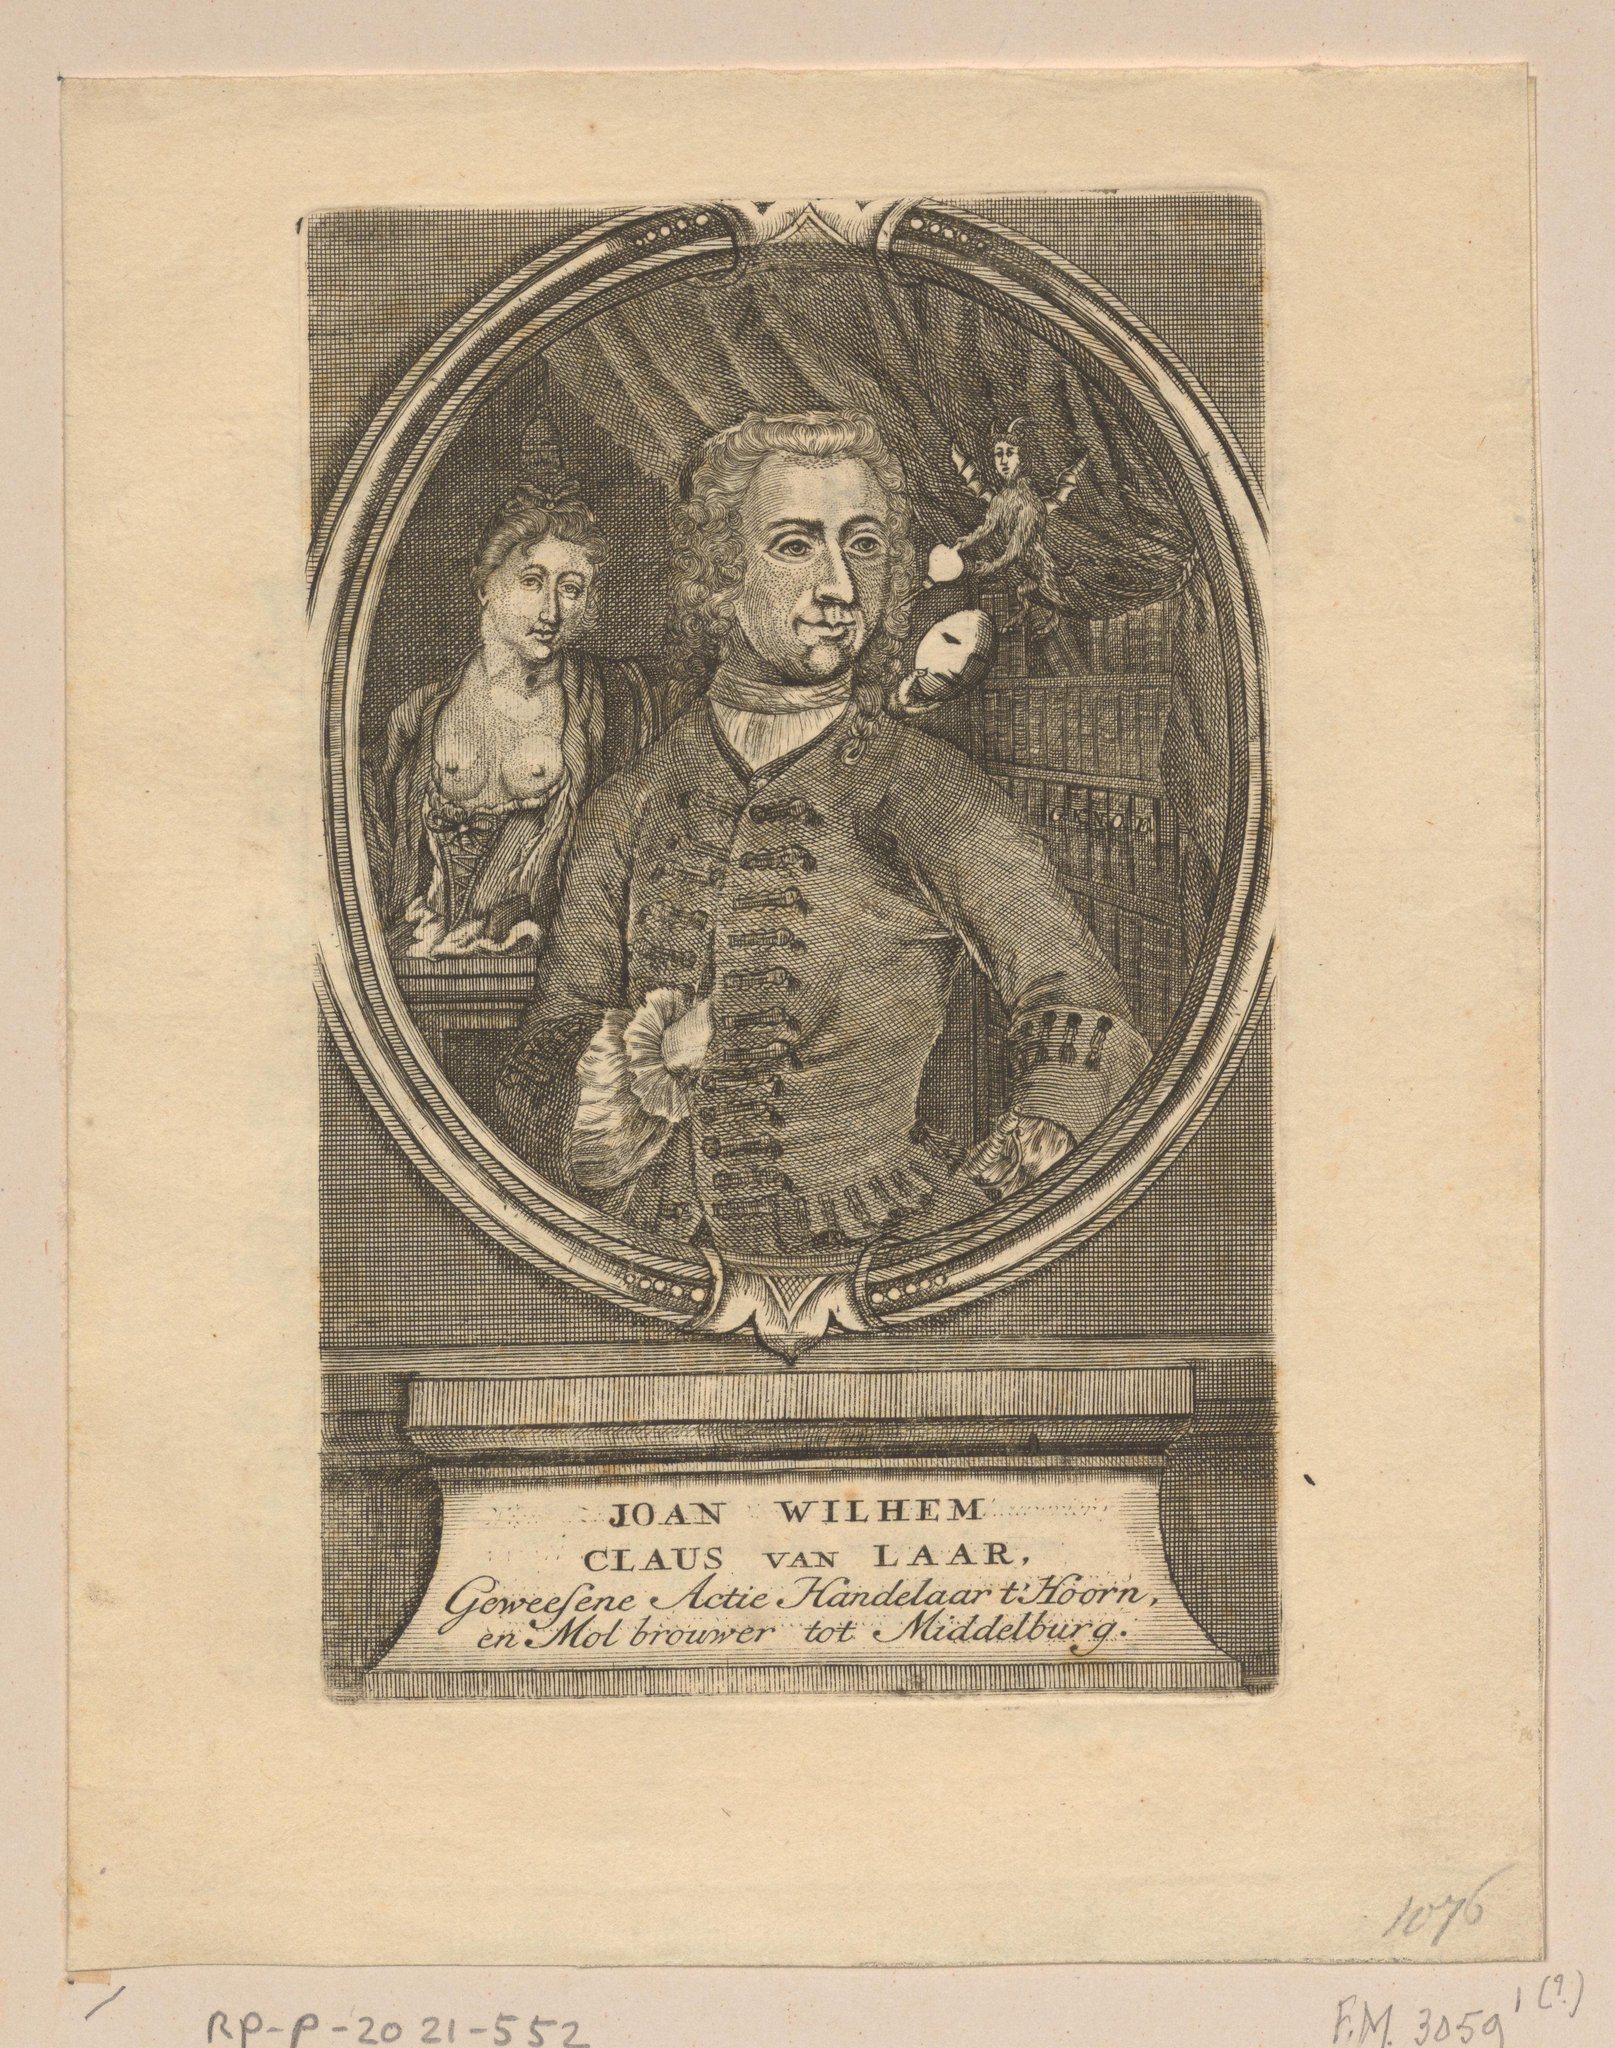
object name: book illustration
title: Portret van Johan Willem Claus van Laar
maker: Anonymous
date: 1746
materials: paper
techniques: engraving, etching, letterpress printing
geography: netherlands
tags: mask, bookshelves, devils in the form of (fabulous) animals, historical persons, portrait of a writer, whore, prostitute, breasts - aa - female human figure, bellows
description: Van Laar staat voor een boekenkast. Een duivel zit met een blaasgalg bij zijn oor. Links achter hem een vrouw met ontblote borsten, mogelijk Christina Sevenhoven. Object bestaat uit twee pagina's, met op de tweede pagina op het recto en verso verzen op het portret.